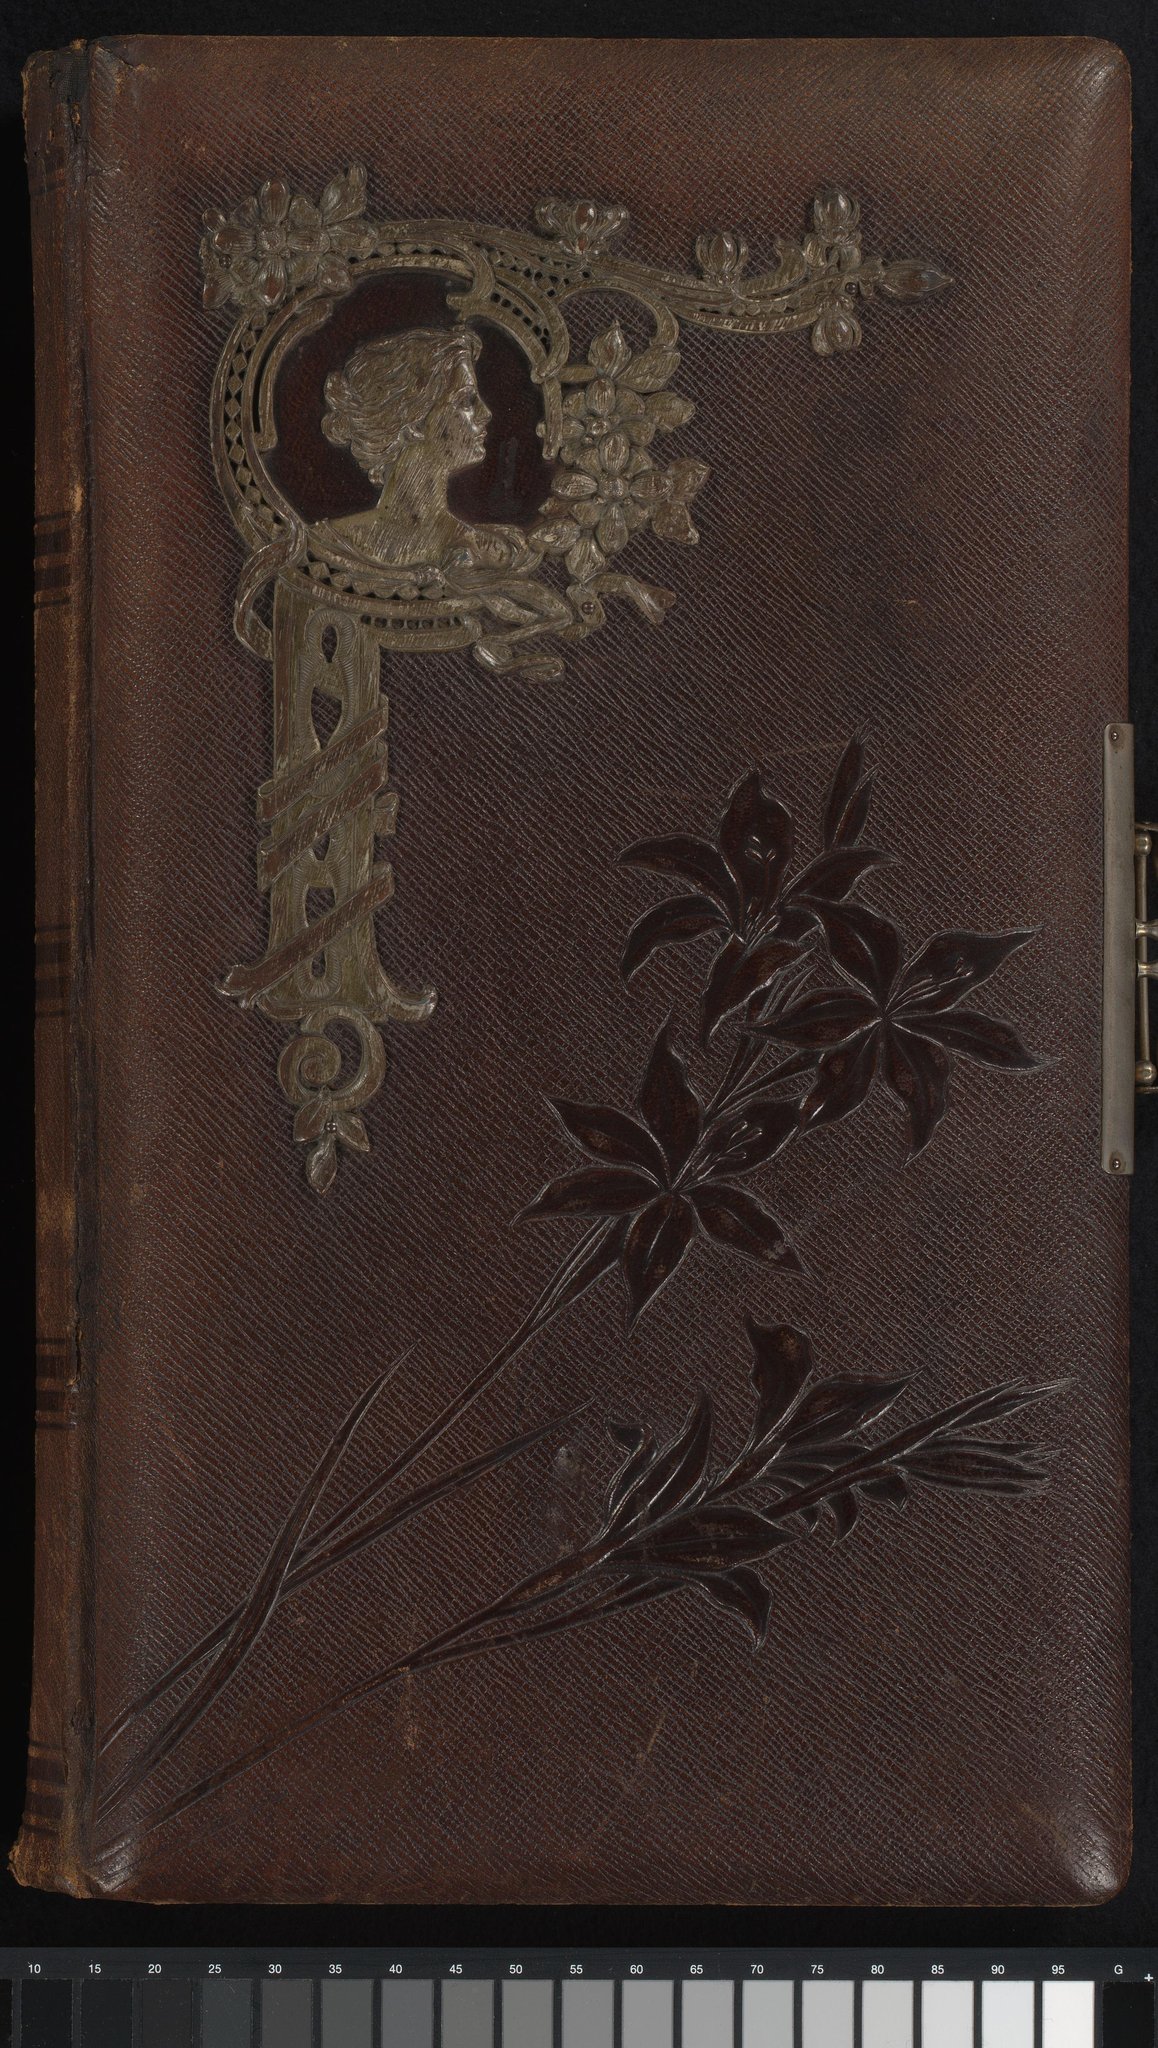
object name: slip in album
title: Fotoalbum (leeg)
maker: Anonymous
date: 1860-1900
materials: cardboard, leather, metal, paper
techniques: decorated paper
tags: flowers, face (+ right side visible; right - (r. hand, r. foot, etc.))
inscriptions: number: ‘753’, collector's mark: ‘DIENST/ VERSPREIDE/ RIJKSKOLLEKTIES/ (...) A 989’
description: Fotoalbum met 28 pagina's met omkaderde passe-partouts voor cartes-de-visite, kabinetfoto's en andere formaten fotokaarten. In totaal is er in het album plaats voor 80 foto's.